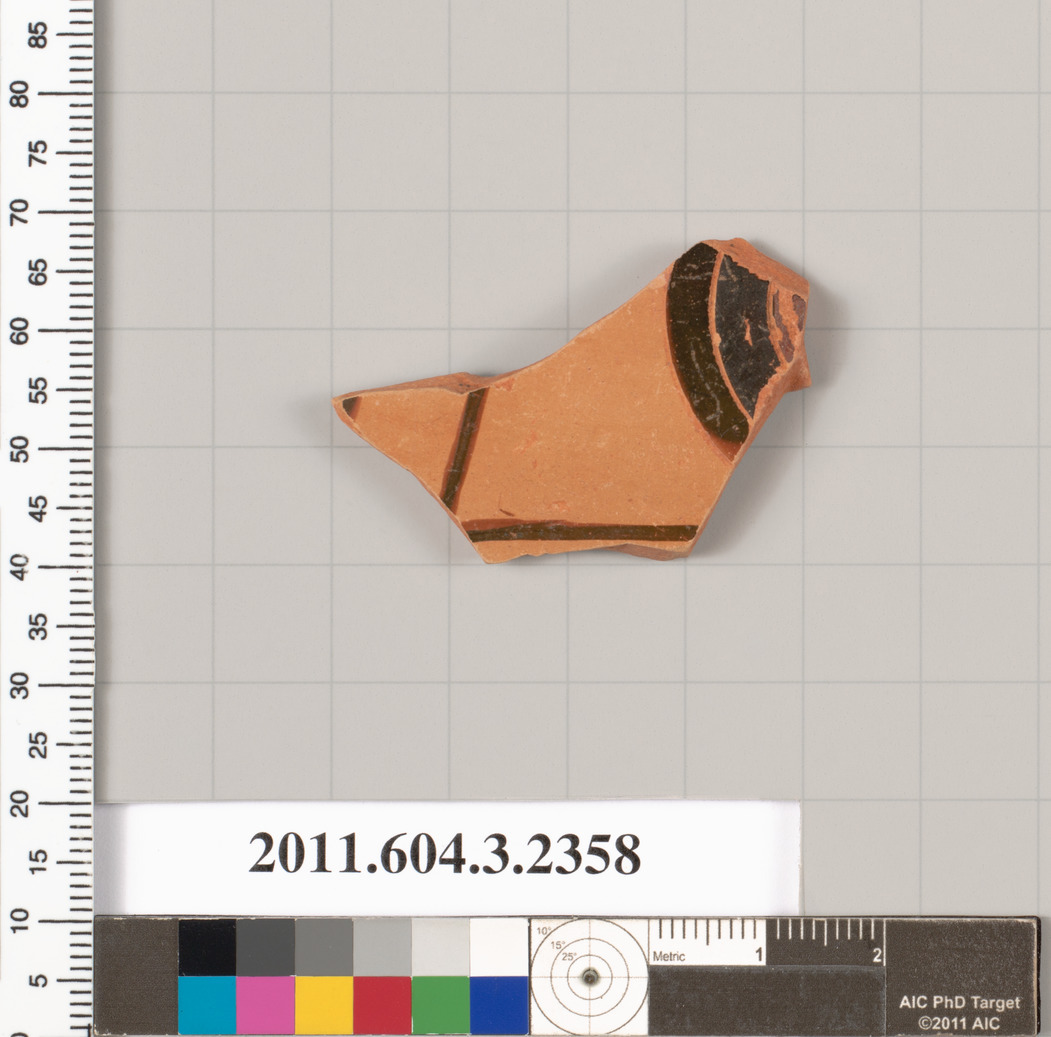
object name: kylix fragment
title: Terracotta fragment of a kylix: eye-cup (drinking cup)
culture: greek, attic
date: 540-530 BCE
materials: terracotta